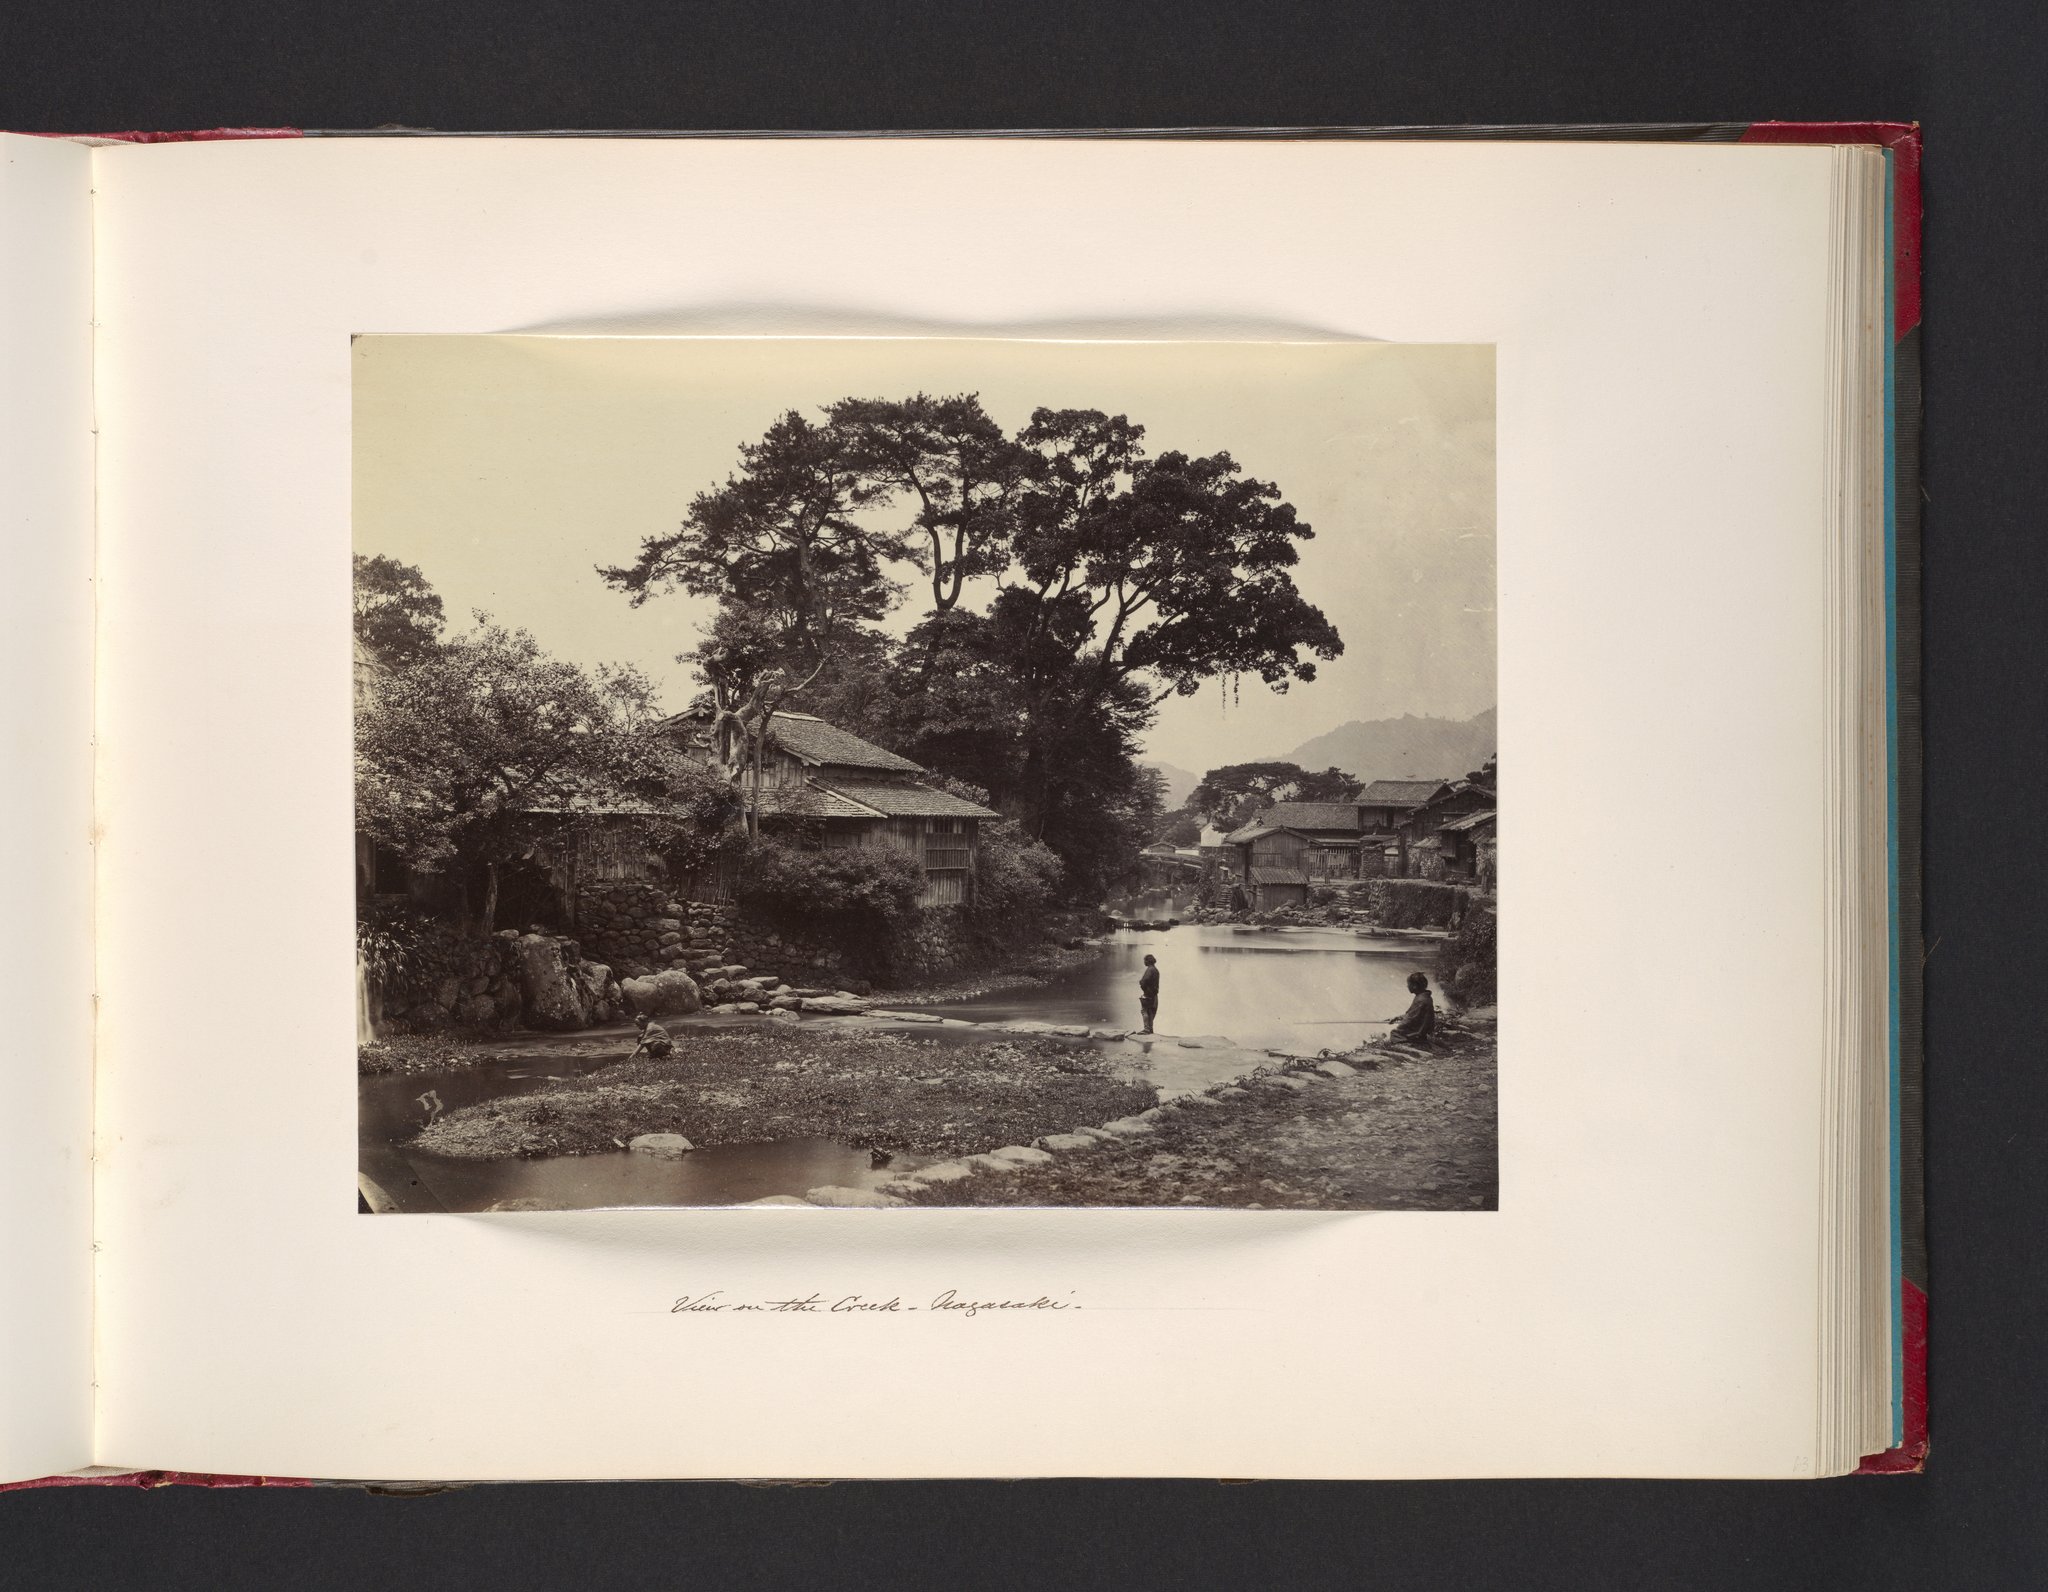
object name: photograph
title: View on the Creek, Nagasaki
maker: john thomson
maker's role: artist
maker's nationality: british, scottish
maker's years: 1837-1921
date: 1865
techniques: albumen silver print, glass negative